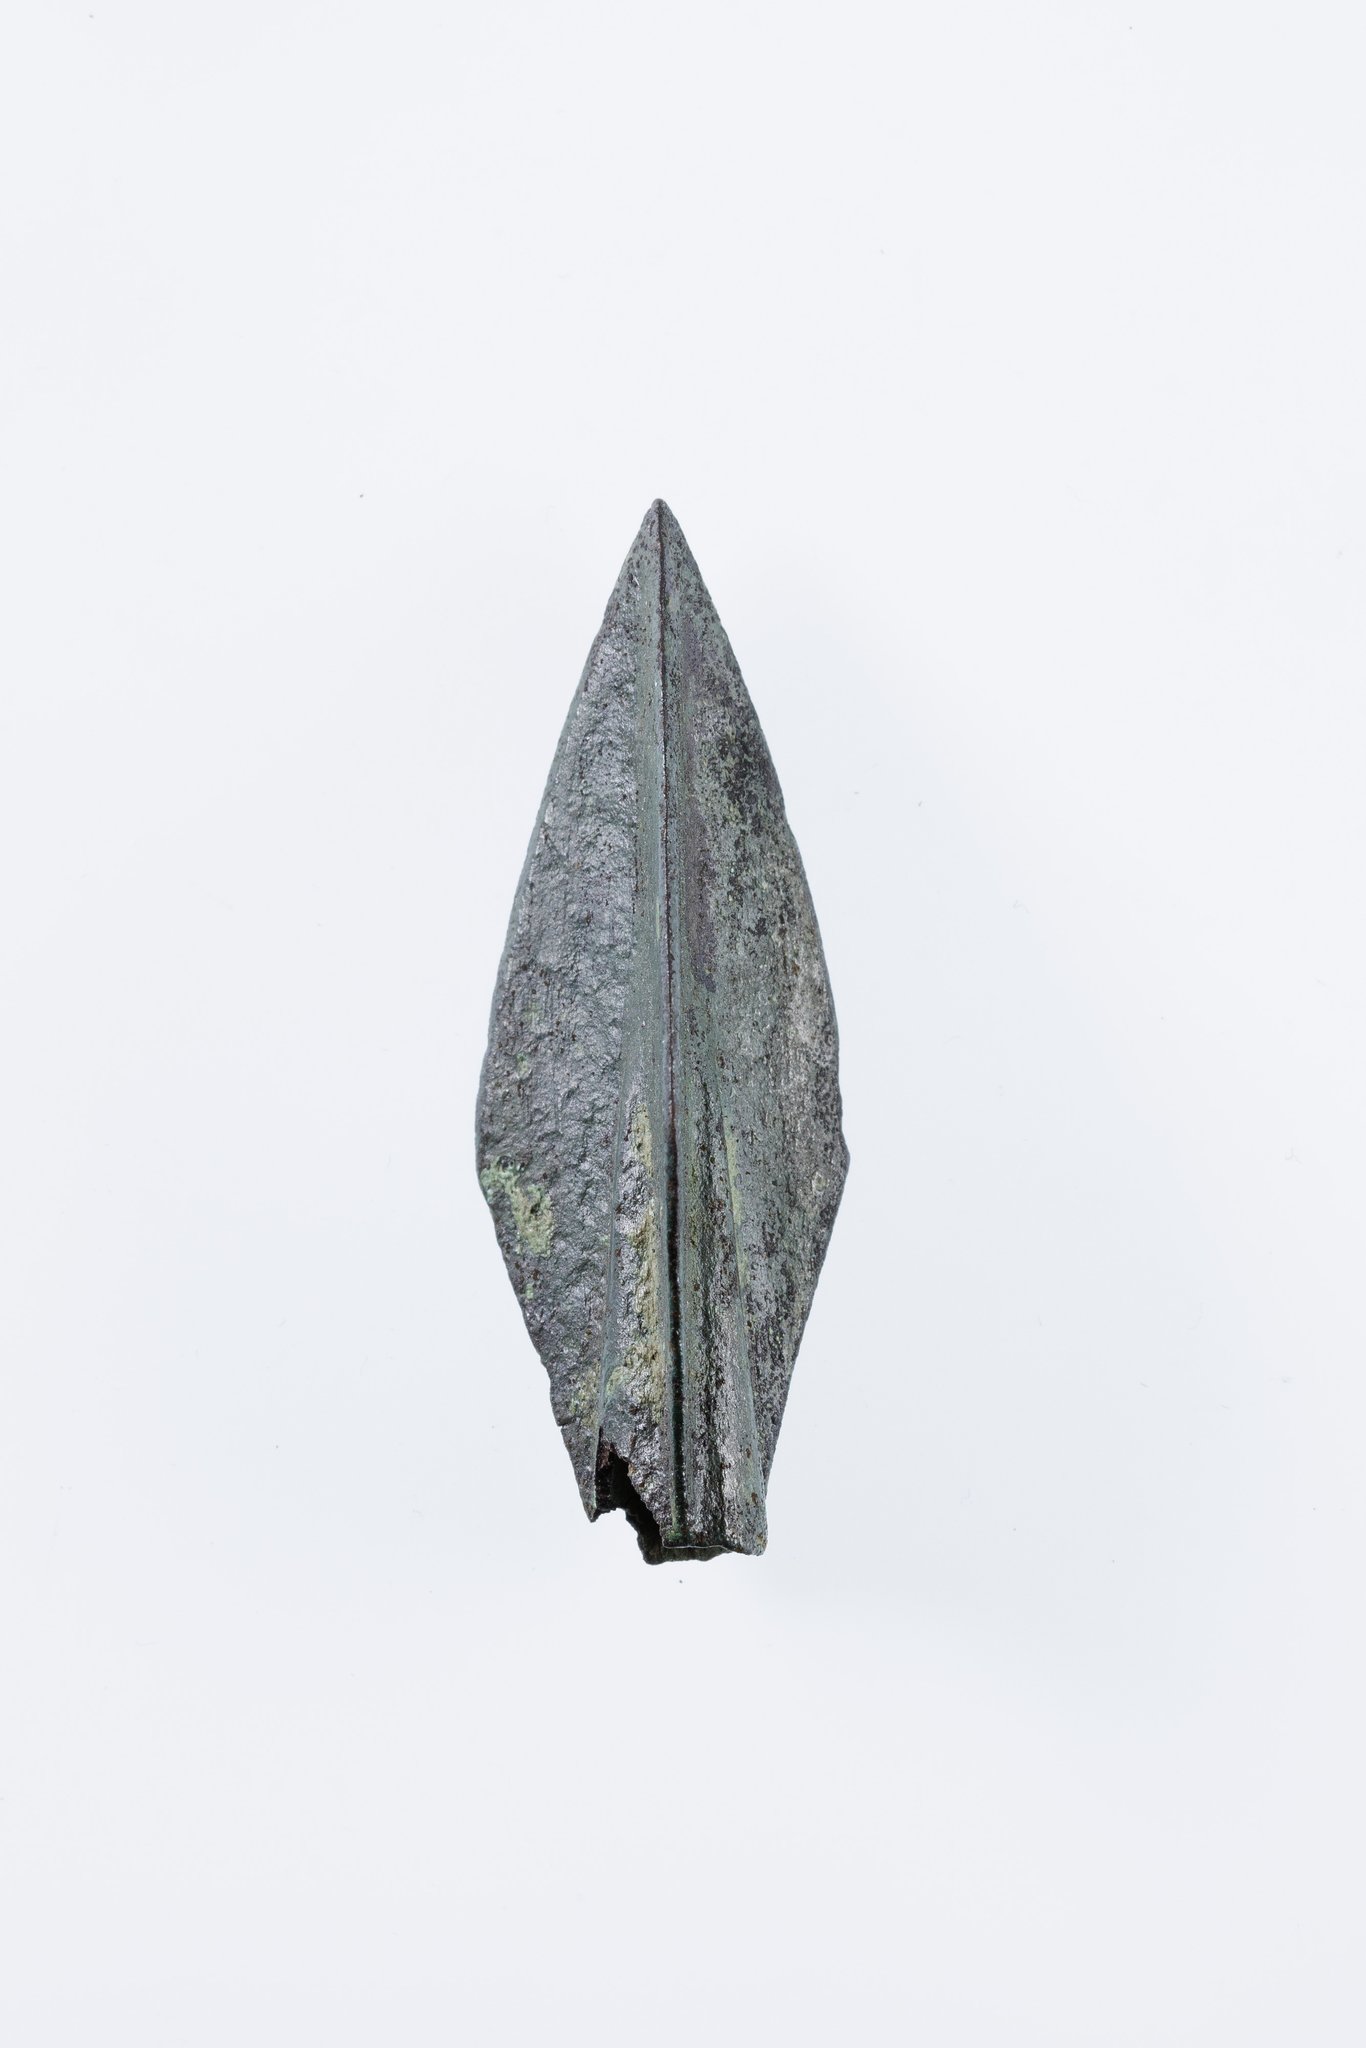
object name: arrow point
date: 664-525 BCE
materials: bronze, copper alloy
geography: egypt